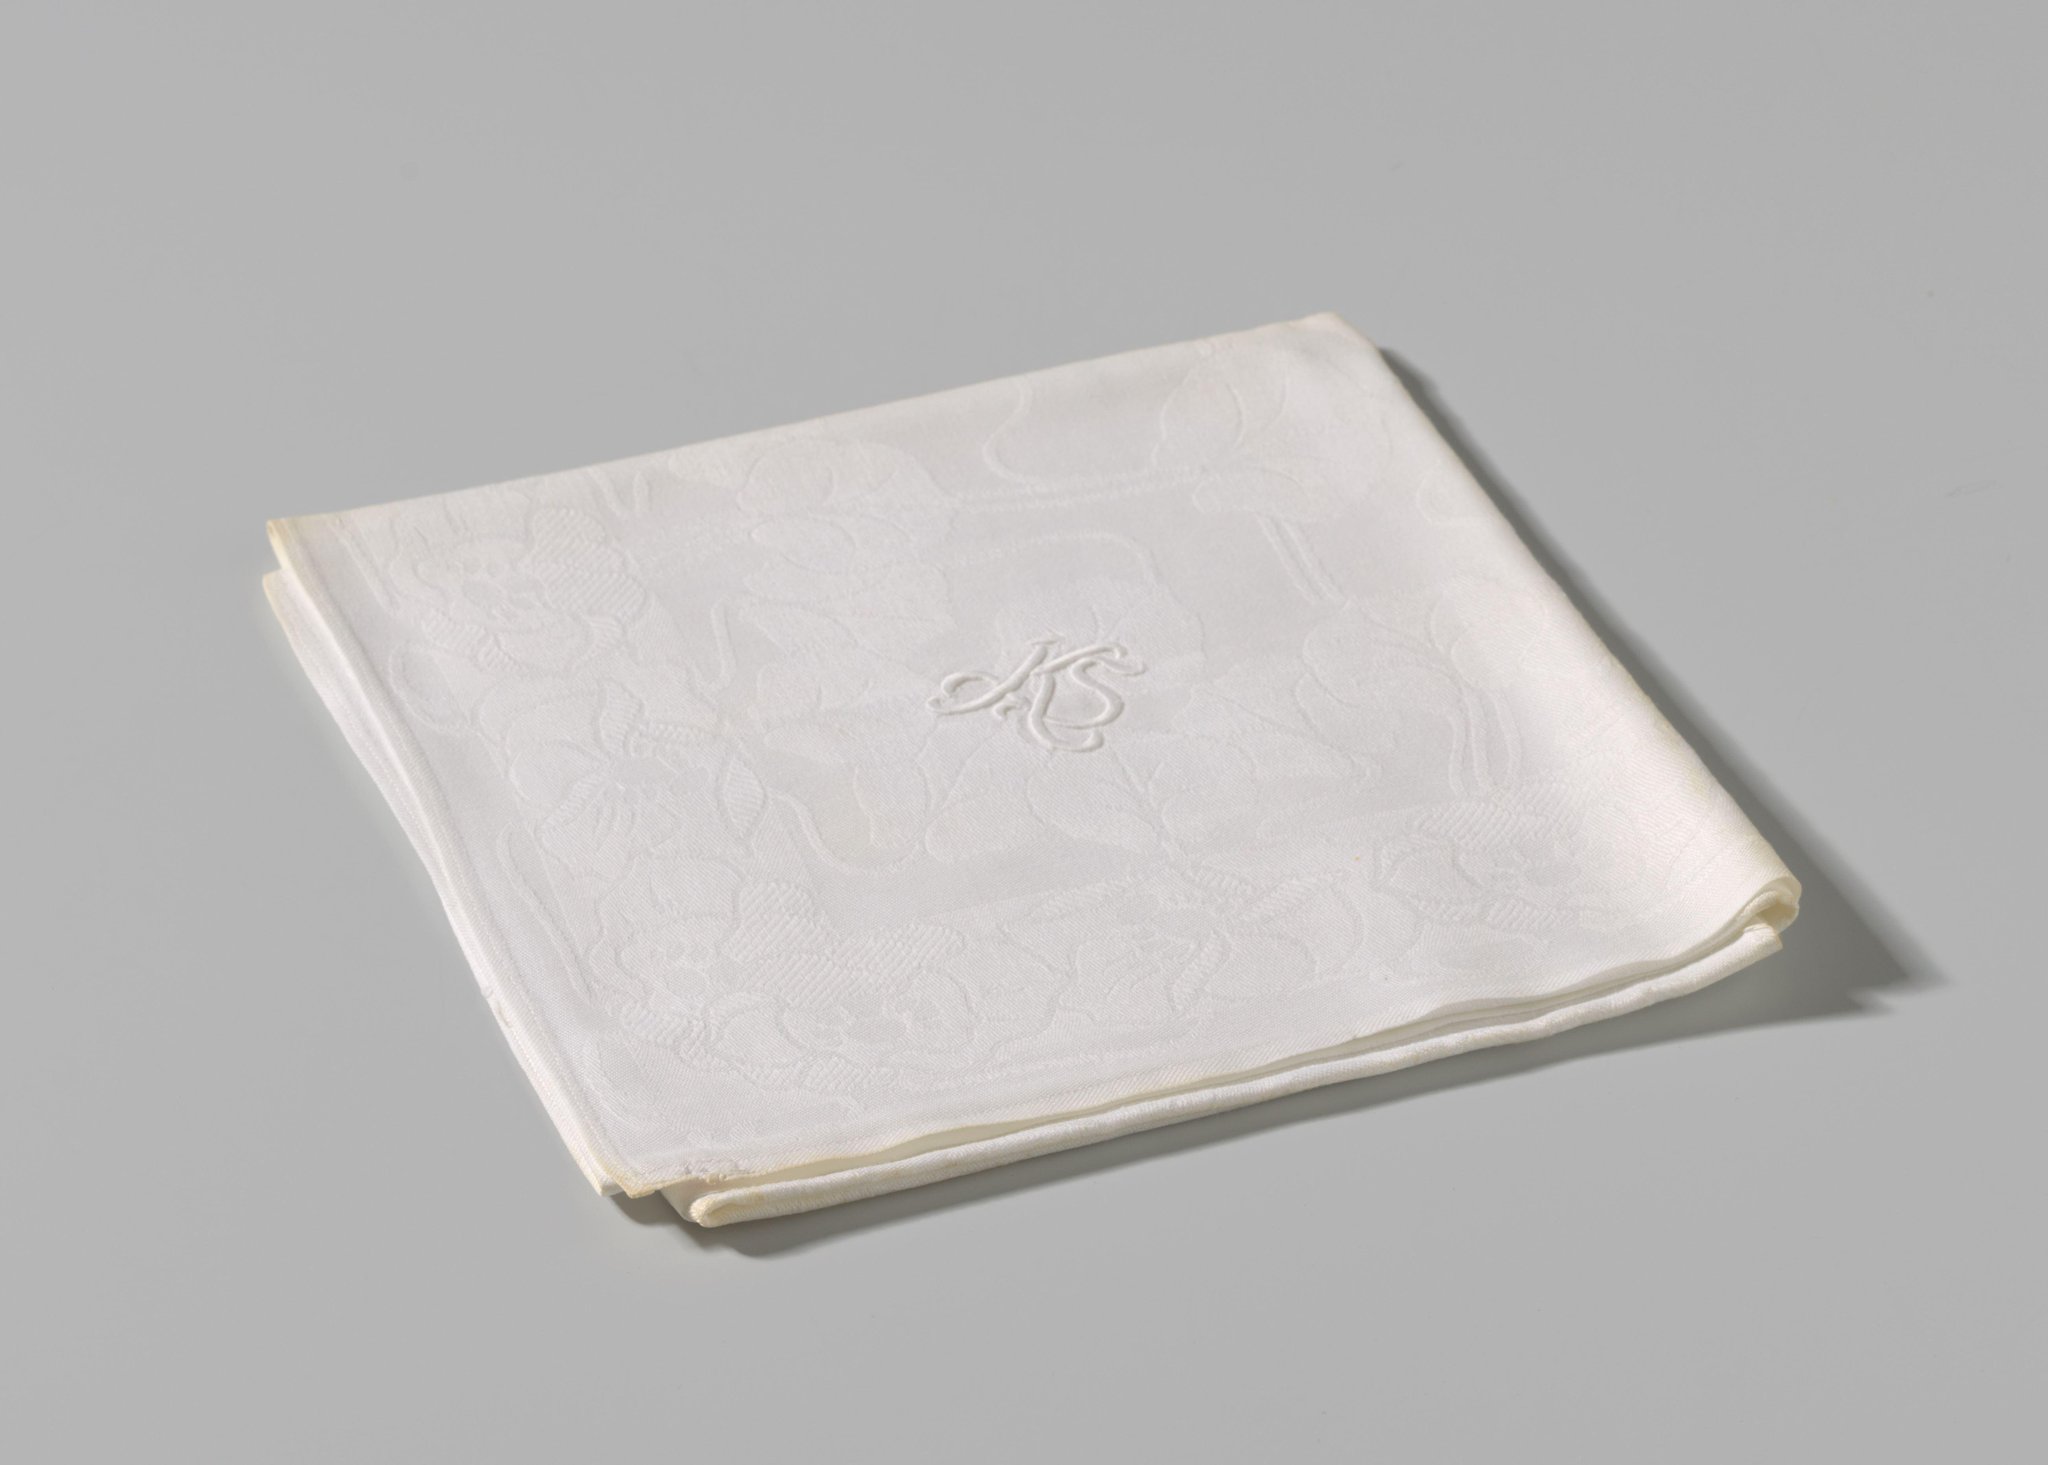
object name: napkin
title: Servet van linnendamast met bladeren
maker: Anonymous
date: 1890-1910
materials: linen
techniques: damask, weave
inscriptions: mark: ‘KUP’, monogram: ‘KS’, number: ‘2559’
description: Servet van linnendamast met bladeren aan kronkelende stengels en een rand van gestileerde bloemen. Het servet heeft een aangenaaid nummer (2559 in rood op wit) en een in wit geborduurd monogram KS. Het servet hoort bij vijf servetten (BK-1970-129-B t/m BK-1970-129-G) en een tafellaken (BK-1970-129-A).